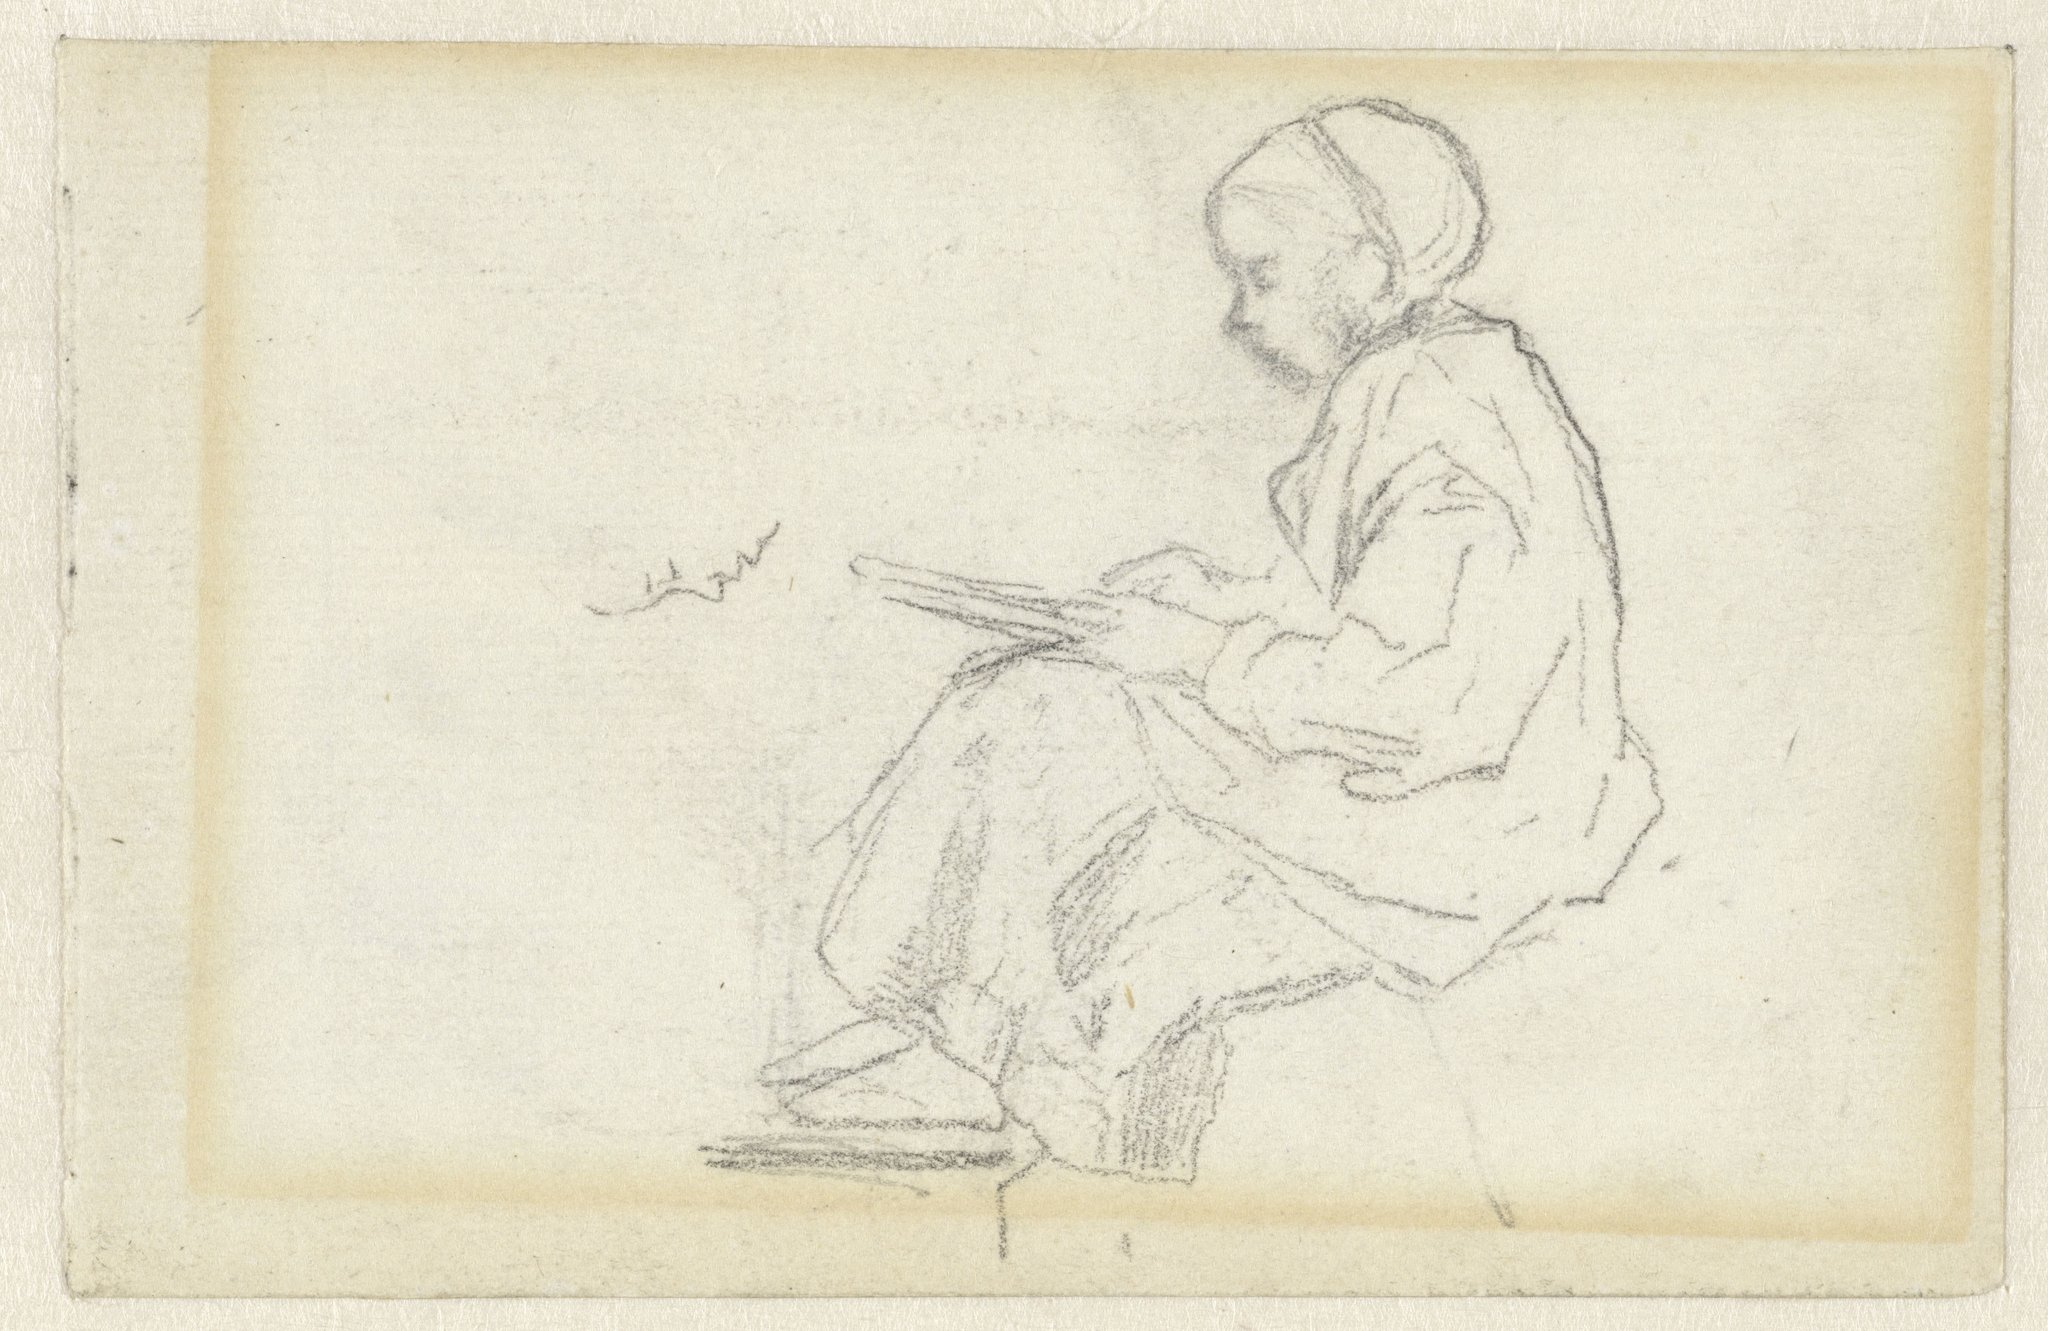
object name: drawing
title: Zittend meisje, schrijvend op een lei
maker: jacob maris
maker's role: draughtsman, painter, print maker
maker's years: 1837-1899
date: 1847-1899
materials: paper, pencil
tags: handwriting, writing as activity